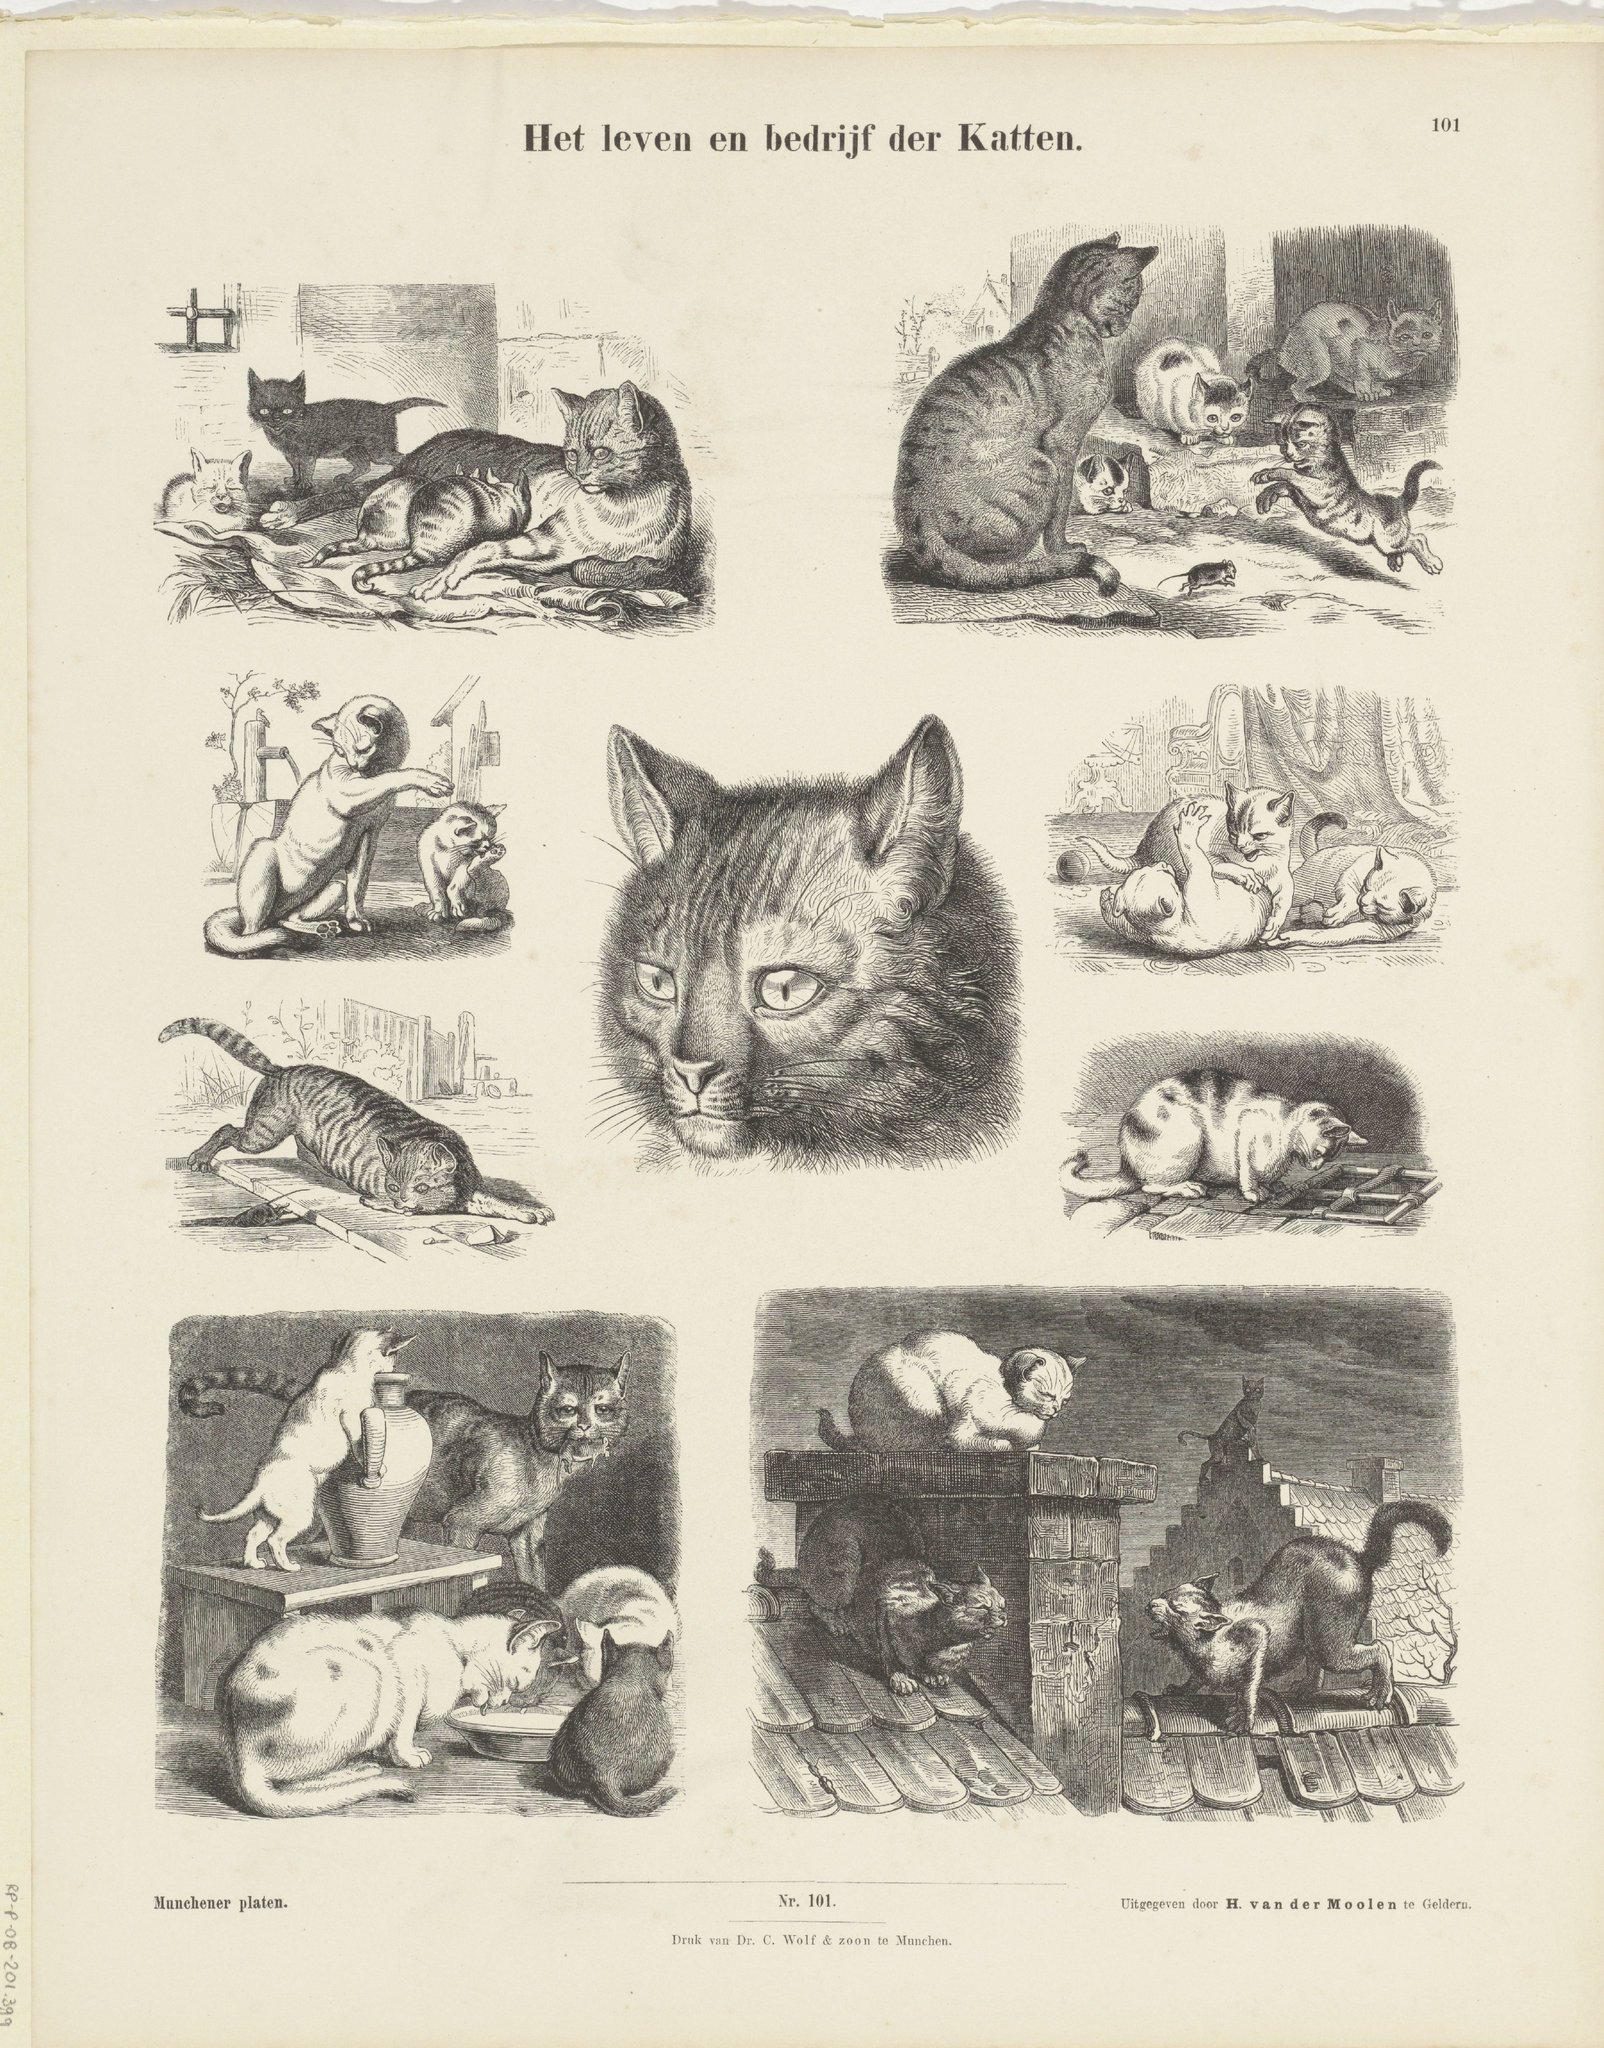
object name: popular print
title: Munchener platen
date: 1843-1920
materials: paper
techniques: letterpress printing, engraving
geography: munich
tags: cat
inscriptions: collector's mark: Lugt 2760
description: Nederlandse editie van een prent uit de reeks "Munchener platen" uitgegeven door K. Braun & Fr. Schneider te München met het adres van wederverkoper Hermann van der Moolen.